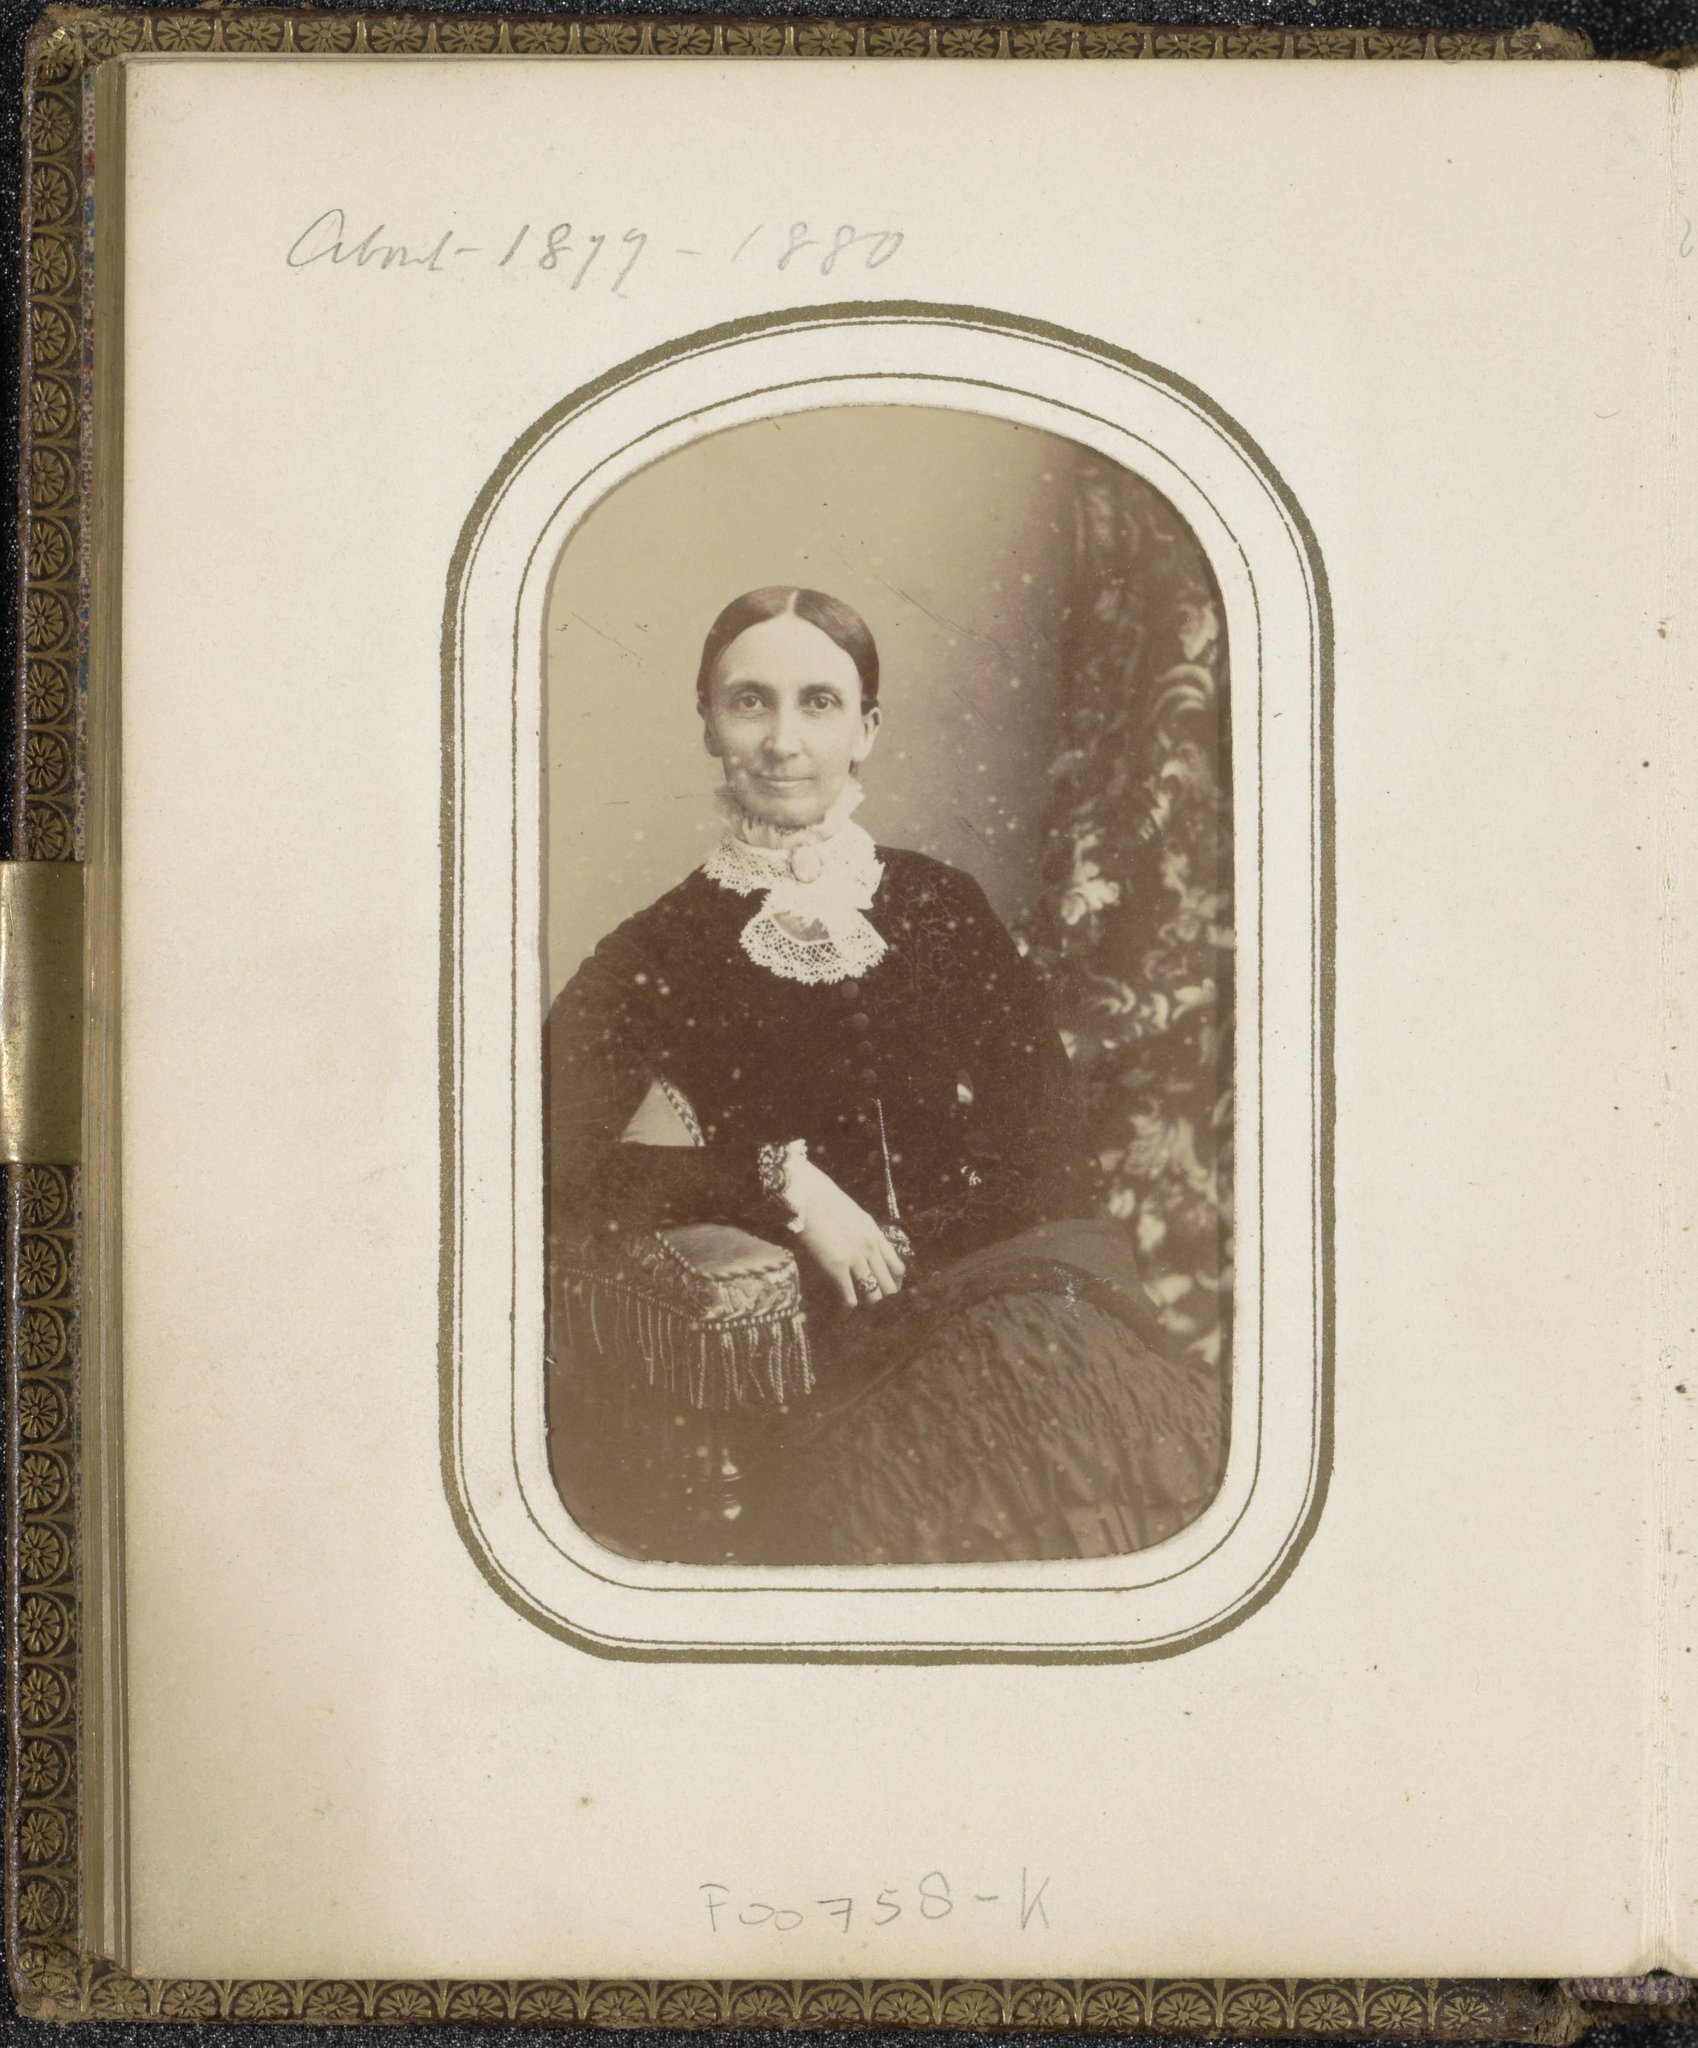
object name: carte de visite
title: Portret van een vrouw met een kanten kraag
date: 1879-1880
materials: cardboard, paper, photographic support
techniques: albumen print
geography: colchester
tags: studio requisites ~ photographer, historical persons, neck-gear: collar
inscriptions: inscription: ‘About 1879-1880’, address: ‘Clochester, 143 High Street’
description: Onderdeel van Engels fotoalbum van E.A. Kettle met 42 cartes-de-visite.